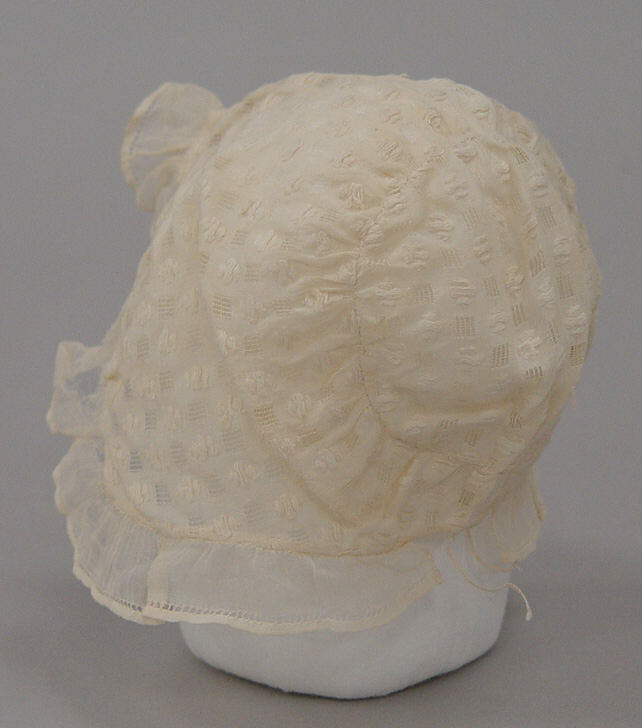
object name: cap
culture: british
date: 1801-1900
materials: cotton